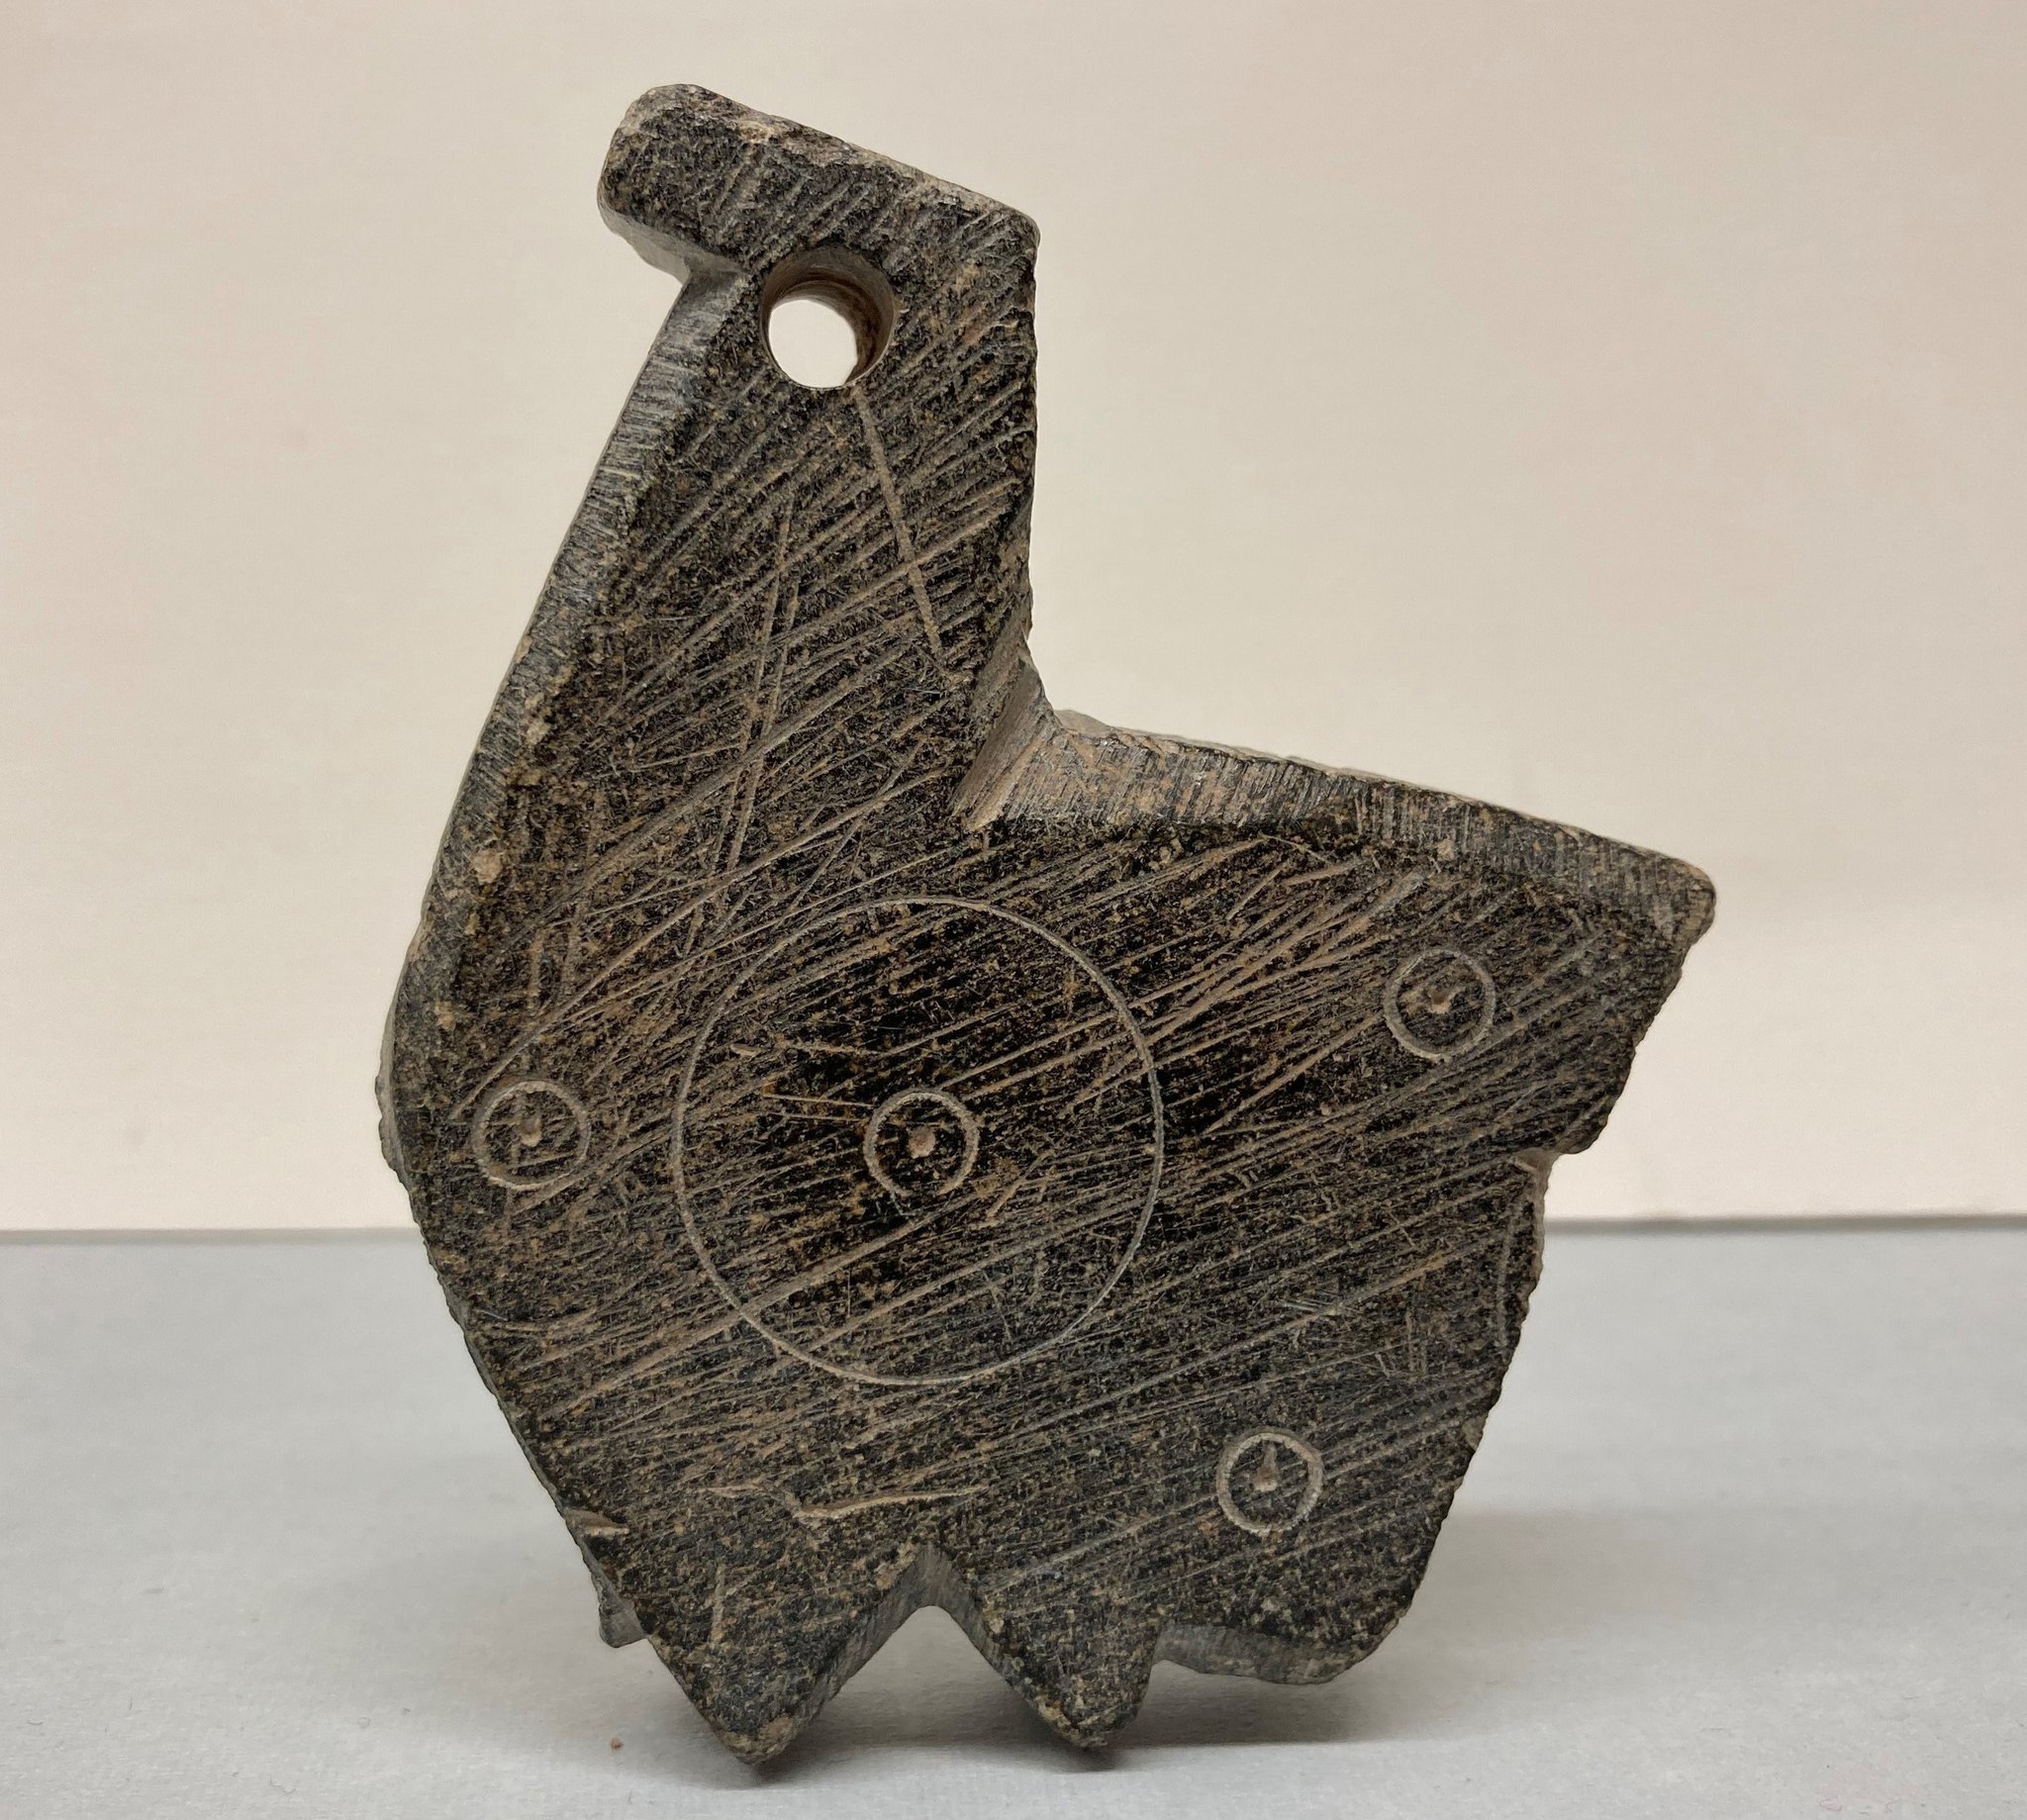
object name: fragment of a cooking spit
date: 701-1300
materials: stone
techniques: carving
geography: iran